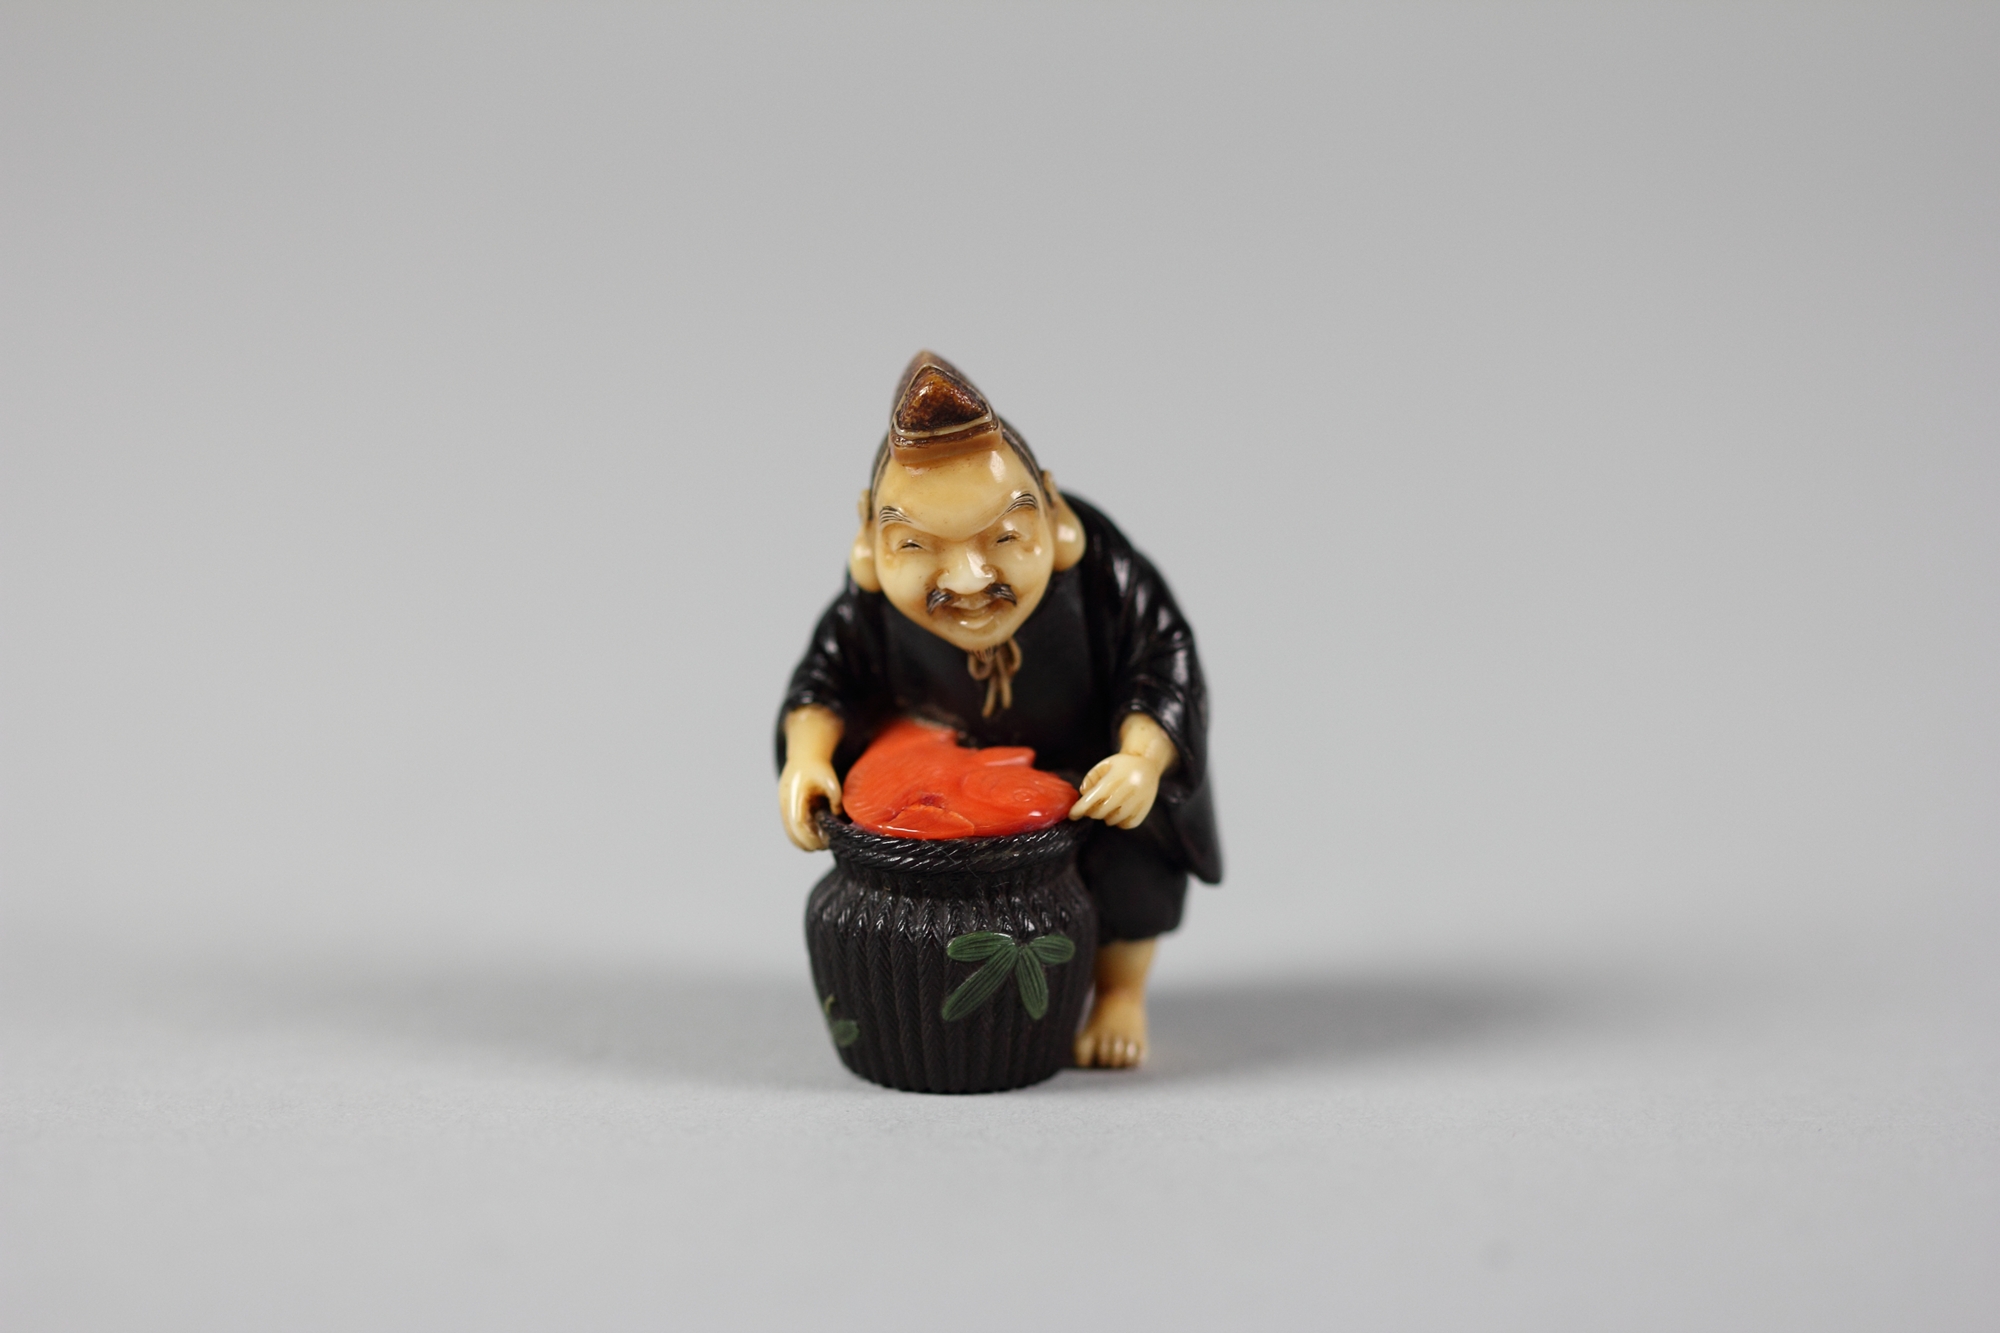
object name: netsuke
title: Netsuke of Ebisu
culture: japanese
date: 1801-1900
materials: ivory, wood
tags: men,baskets